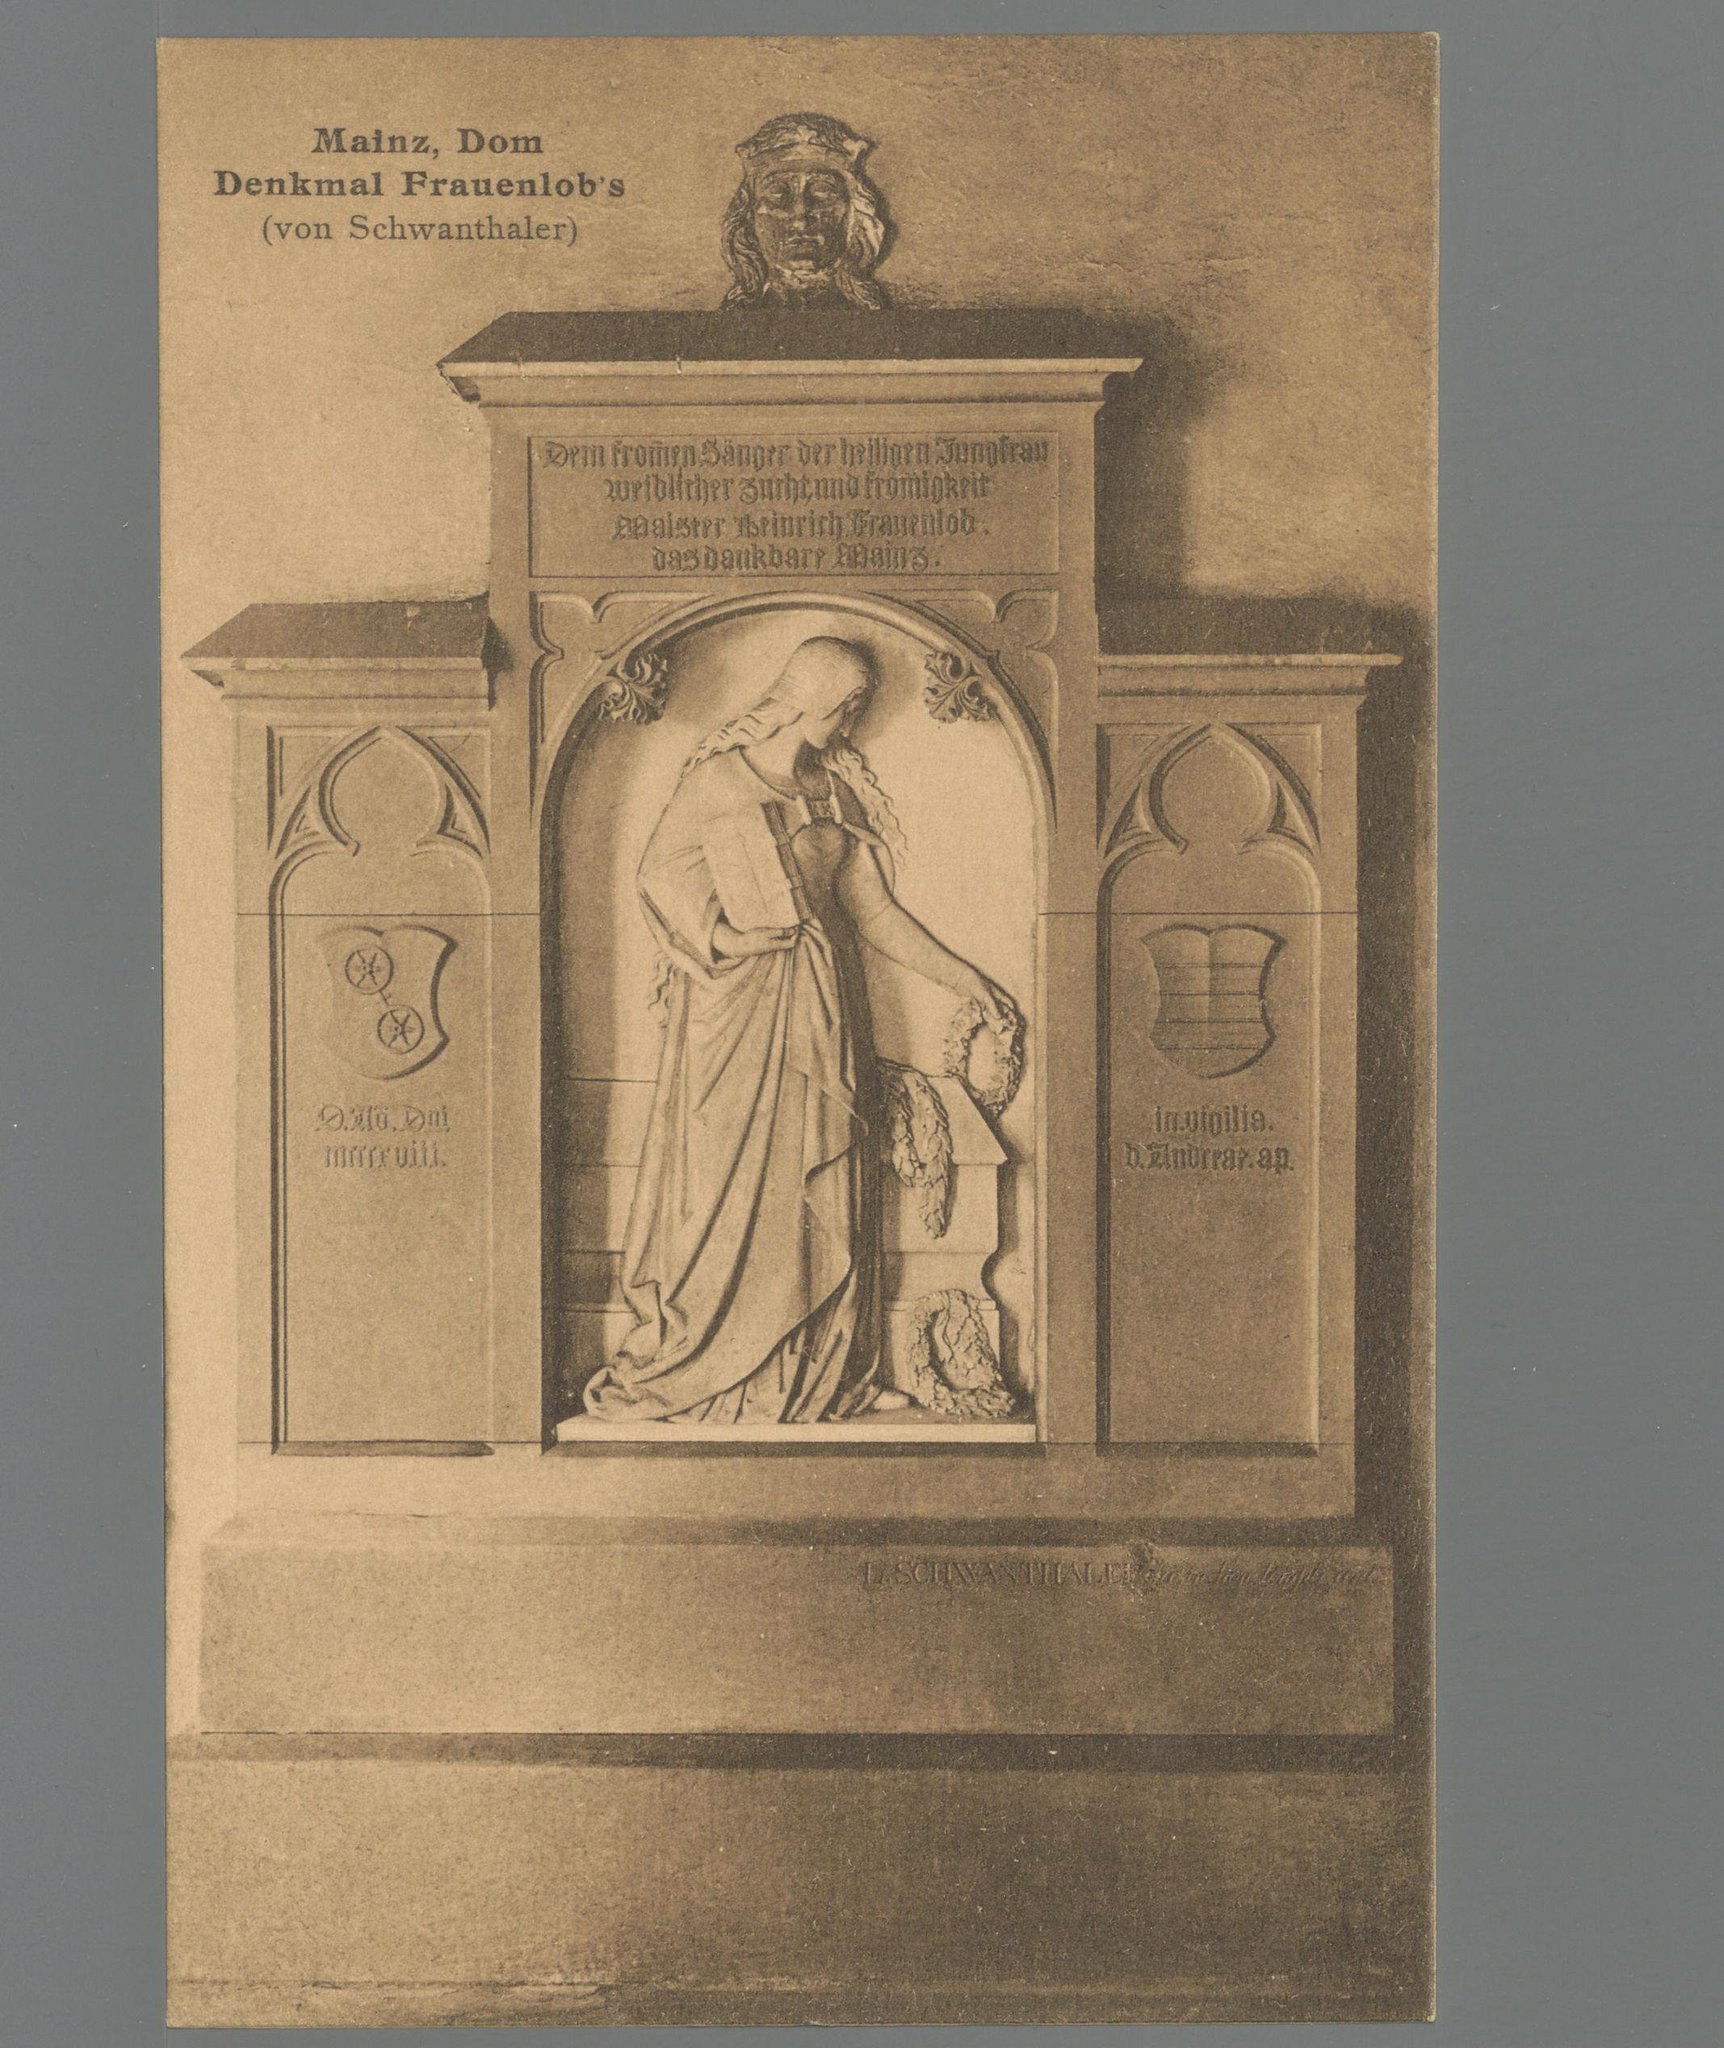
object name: ansichtkaart, prentbriefkaart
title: Mainz, Dom, Denkmal Frauenlob's (von Schwanthaler)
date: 1906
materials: cardboard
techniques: photograph, writing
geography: mainz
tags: interior of church, monument, statue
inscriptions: date